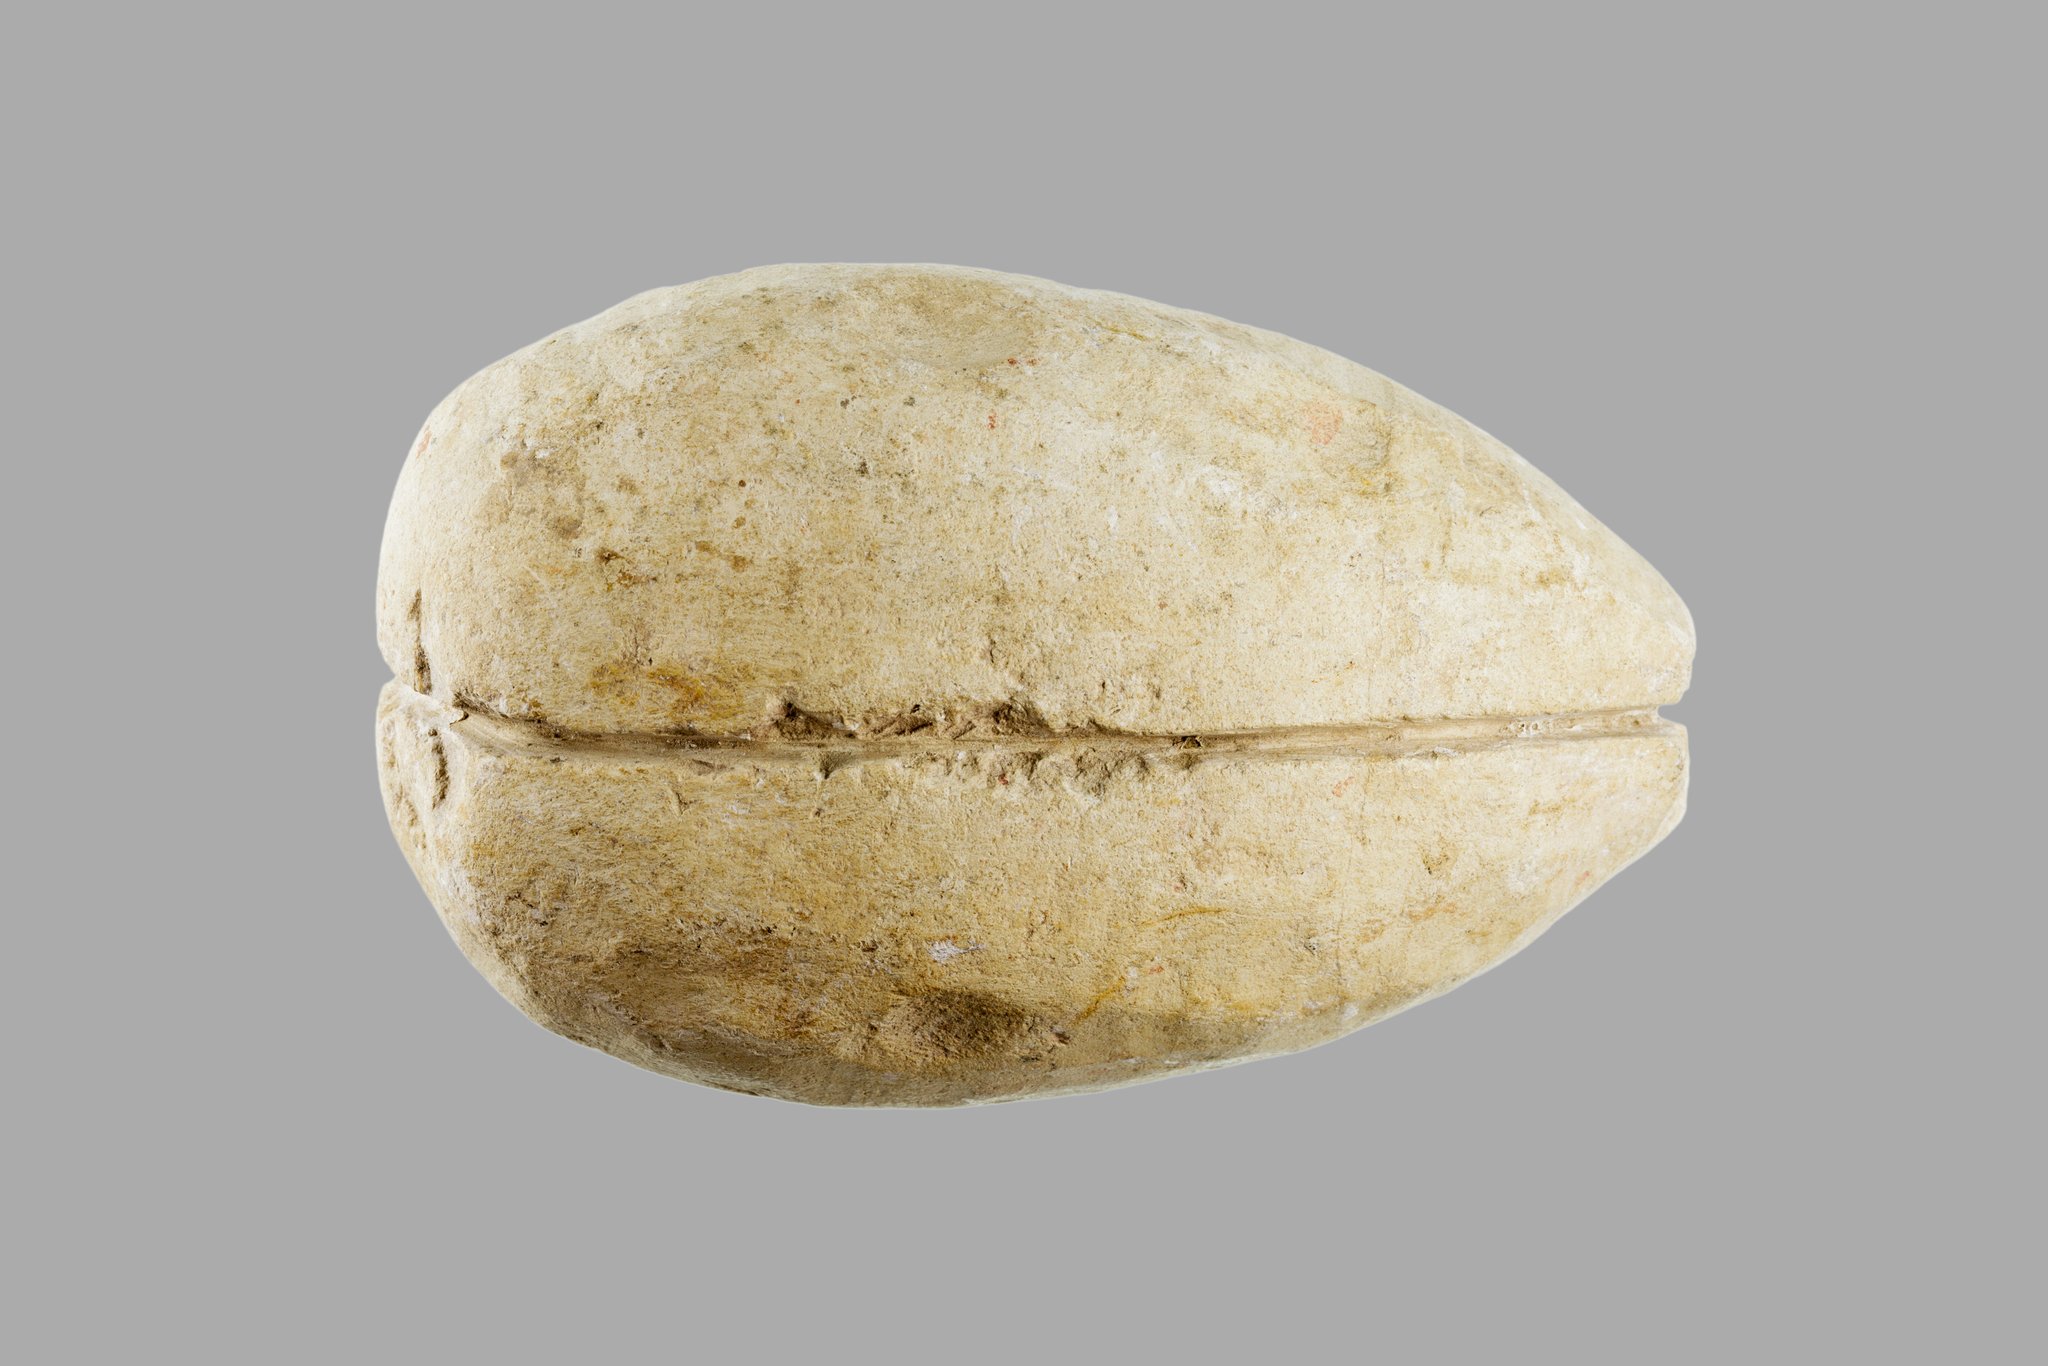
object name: axe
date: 1981-1975 BCE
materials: limestone, paint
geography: egypt